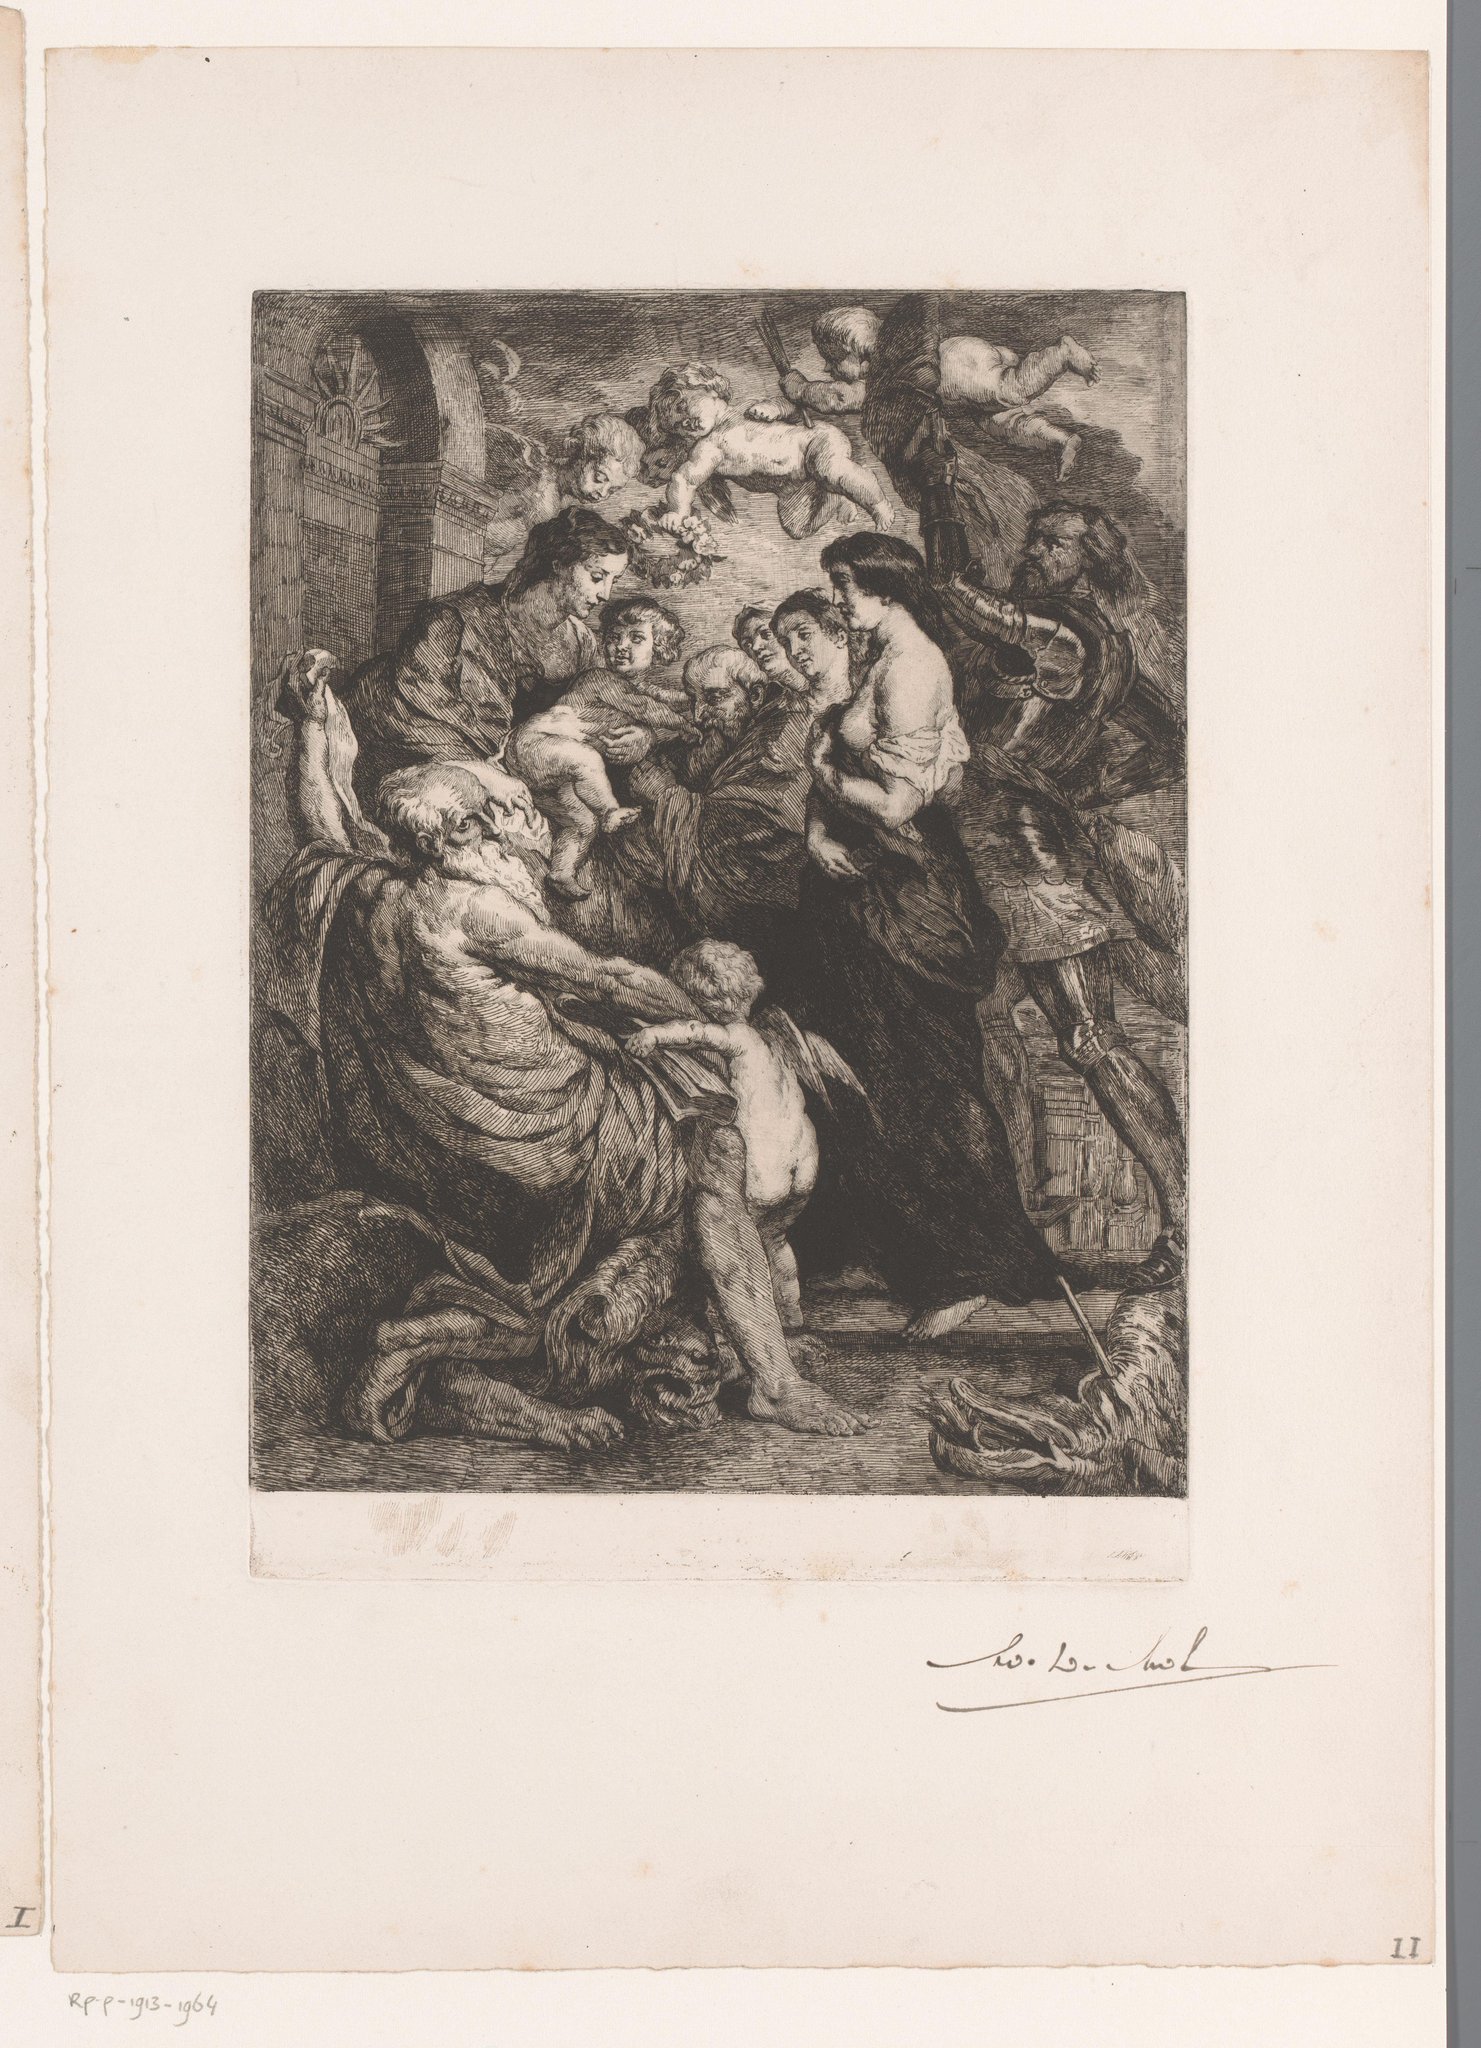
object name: print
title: Diverse heiligen vereren Maria en het Christuskind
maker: adolphe léonard de mol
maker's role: print maker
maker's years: 1834-1877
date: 1844-1877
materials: paper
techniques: etching, intaglio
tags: madonna: i.e. mary with the christ-child, the monk and hermit jerome (hieronymus); possible attributes: book, cardinal's hat, crucifix, hour-glass, lion, skull, stone, the warrior martyr george (georgius); possible attributes: banner (red cross on white field), (red) cross, dragon, (white) horse, broken lance, shield (with cross), sword, the penitent harlot mary magdalene; possible attributes: book (or scroll), crown, crown of thorns, crucifix, jar of ointment, mirror, musical instrument, palm-branch, rosary, scourge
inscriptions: collector's mark: Lugt 2228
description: Maria houdt het Christukind in haar armen en wordt vereerd door onder andere Hiëronymus, Joris en Maria Magdalena.